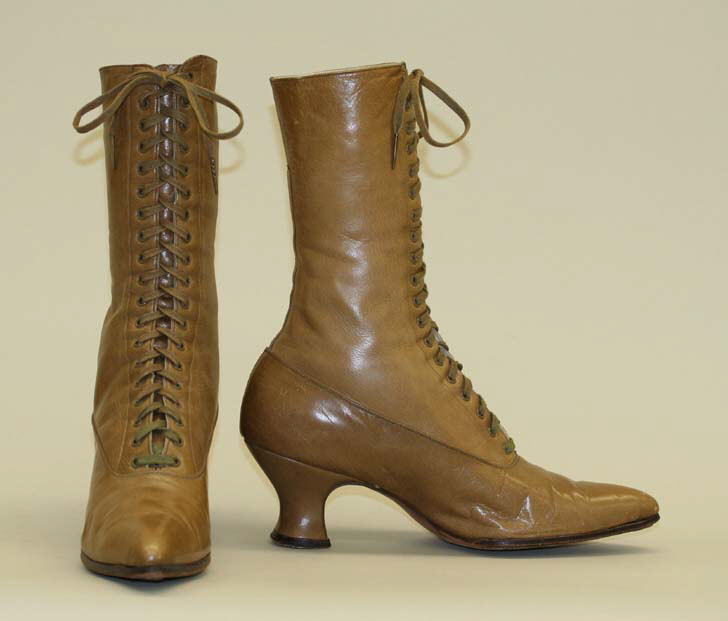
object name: boot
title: Boots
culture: american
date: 1899-1900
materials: leather